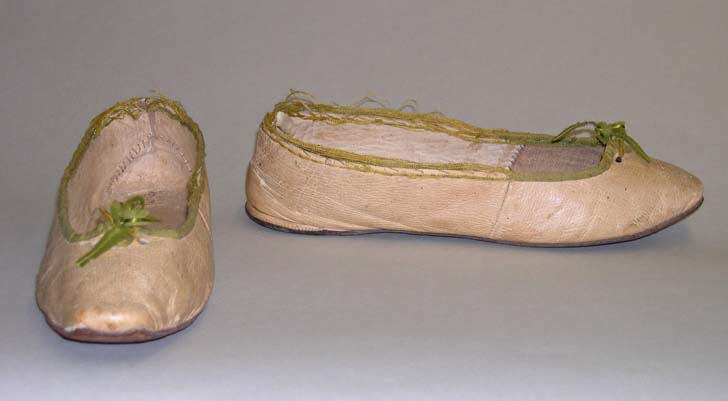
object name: shoe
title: Shoes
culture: american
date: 1810-1819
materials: leather